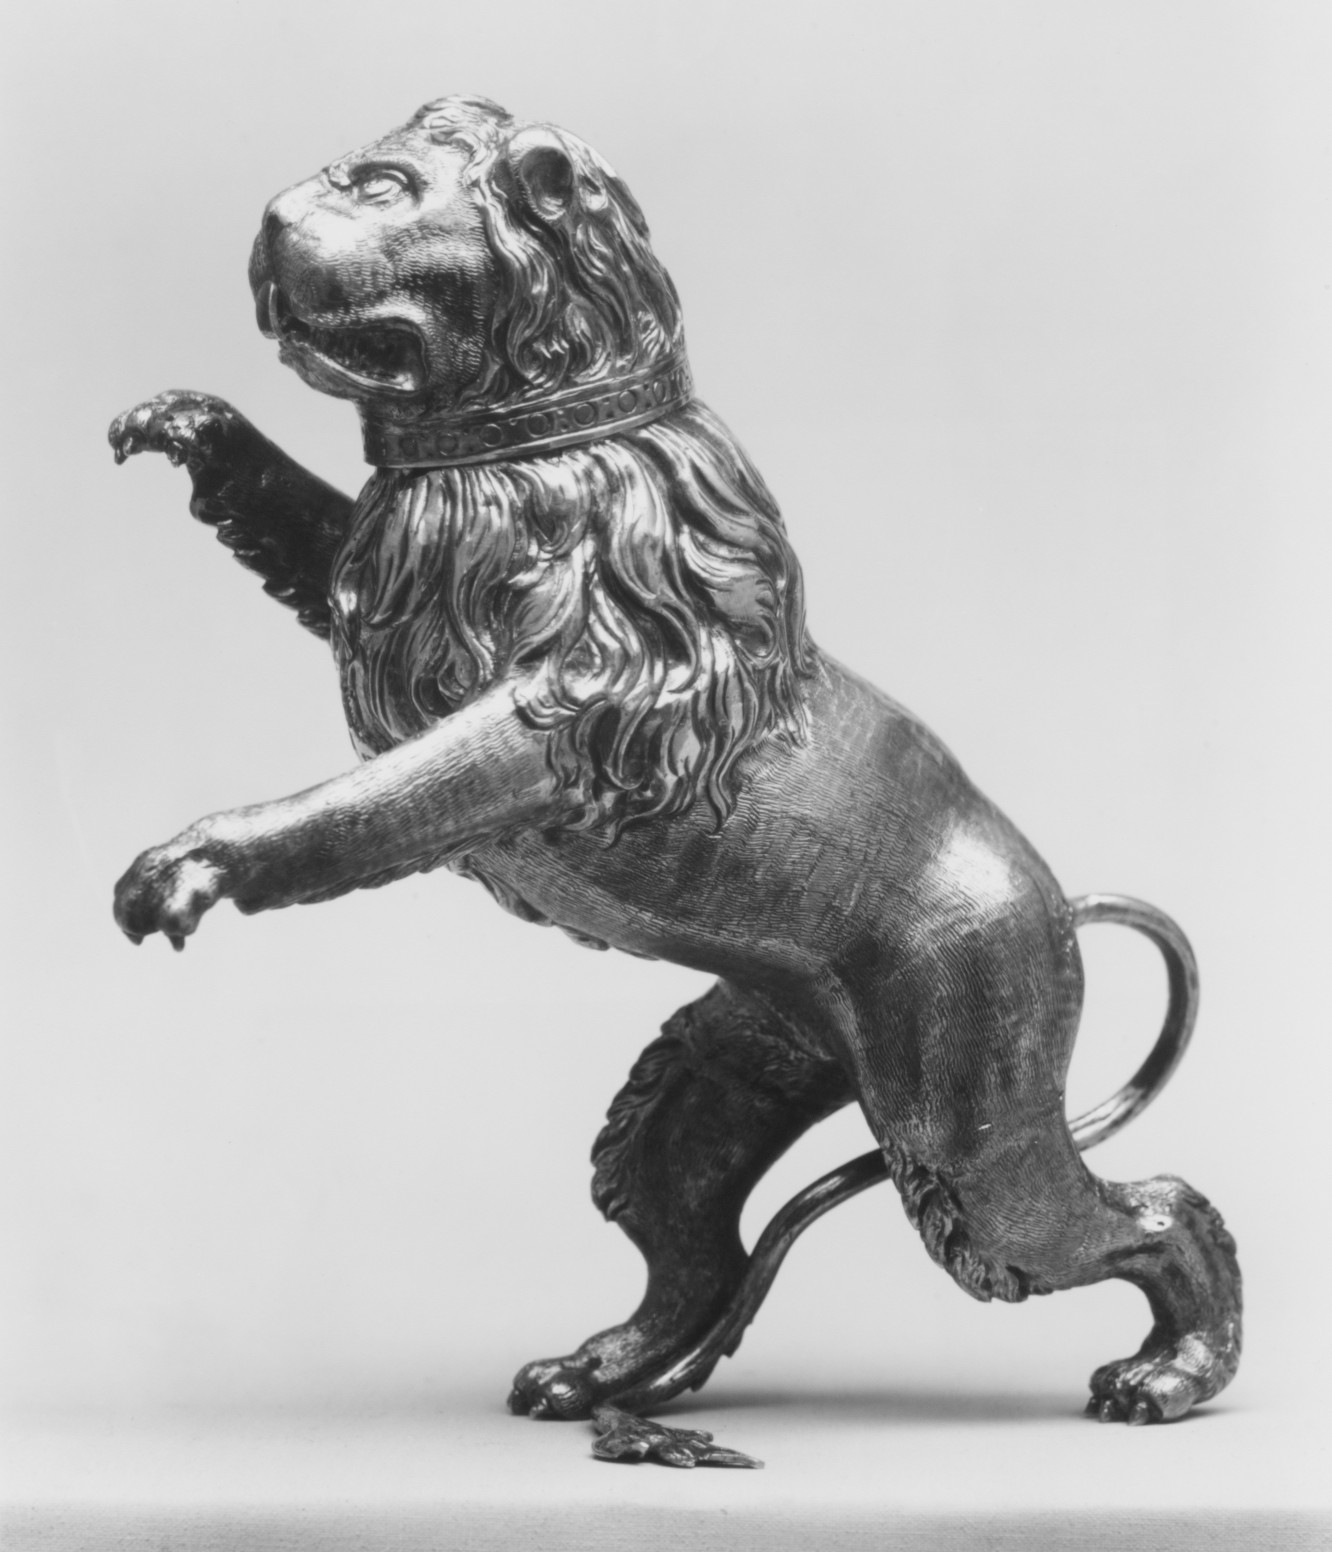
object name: cup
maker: leonard umbach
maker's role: maker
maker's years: 1514-1614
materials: silver gilt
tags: lions